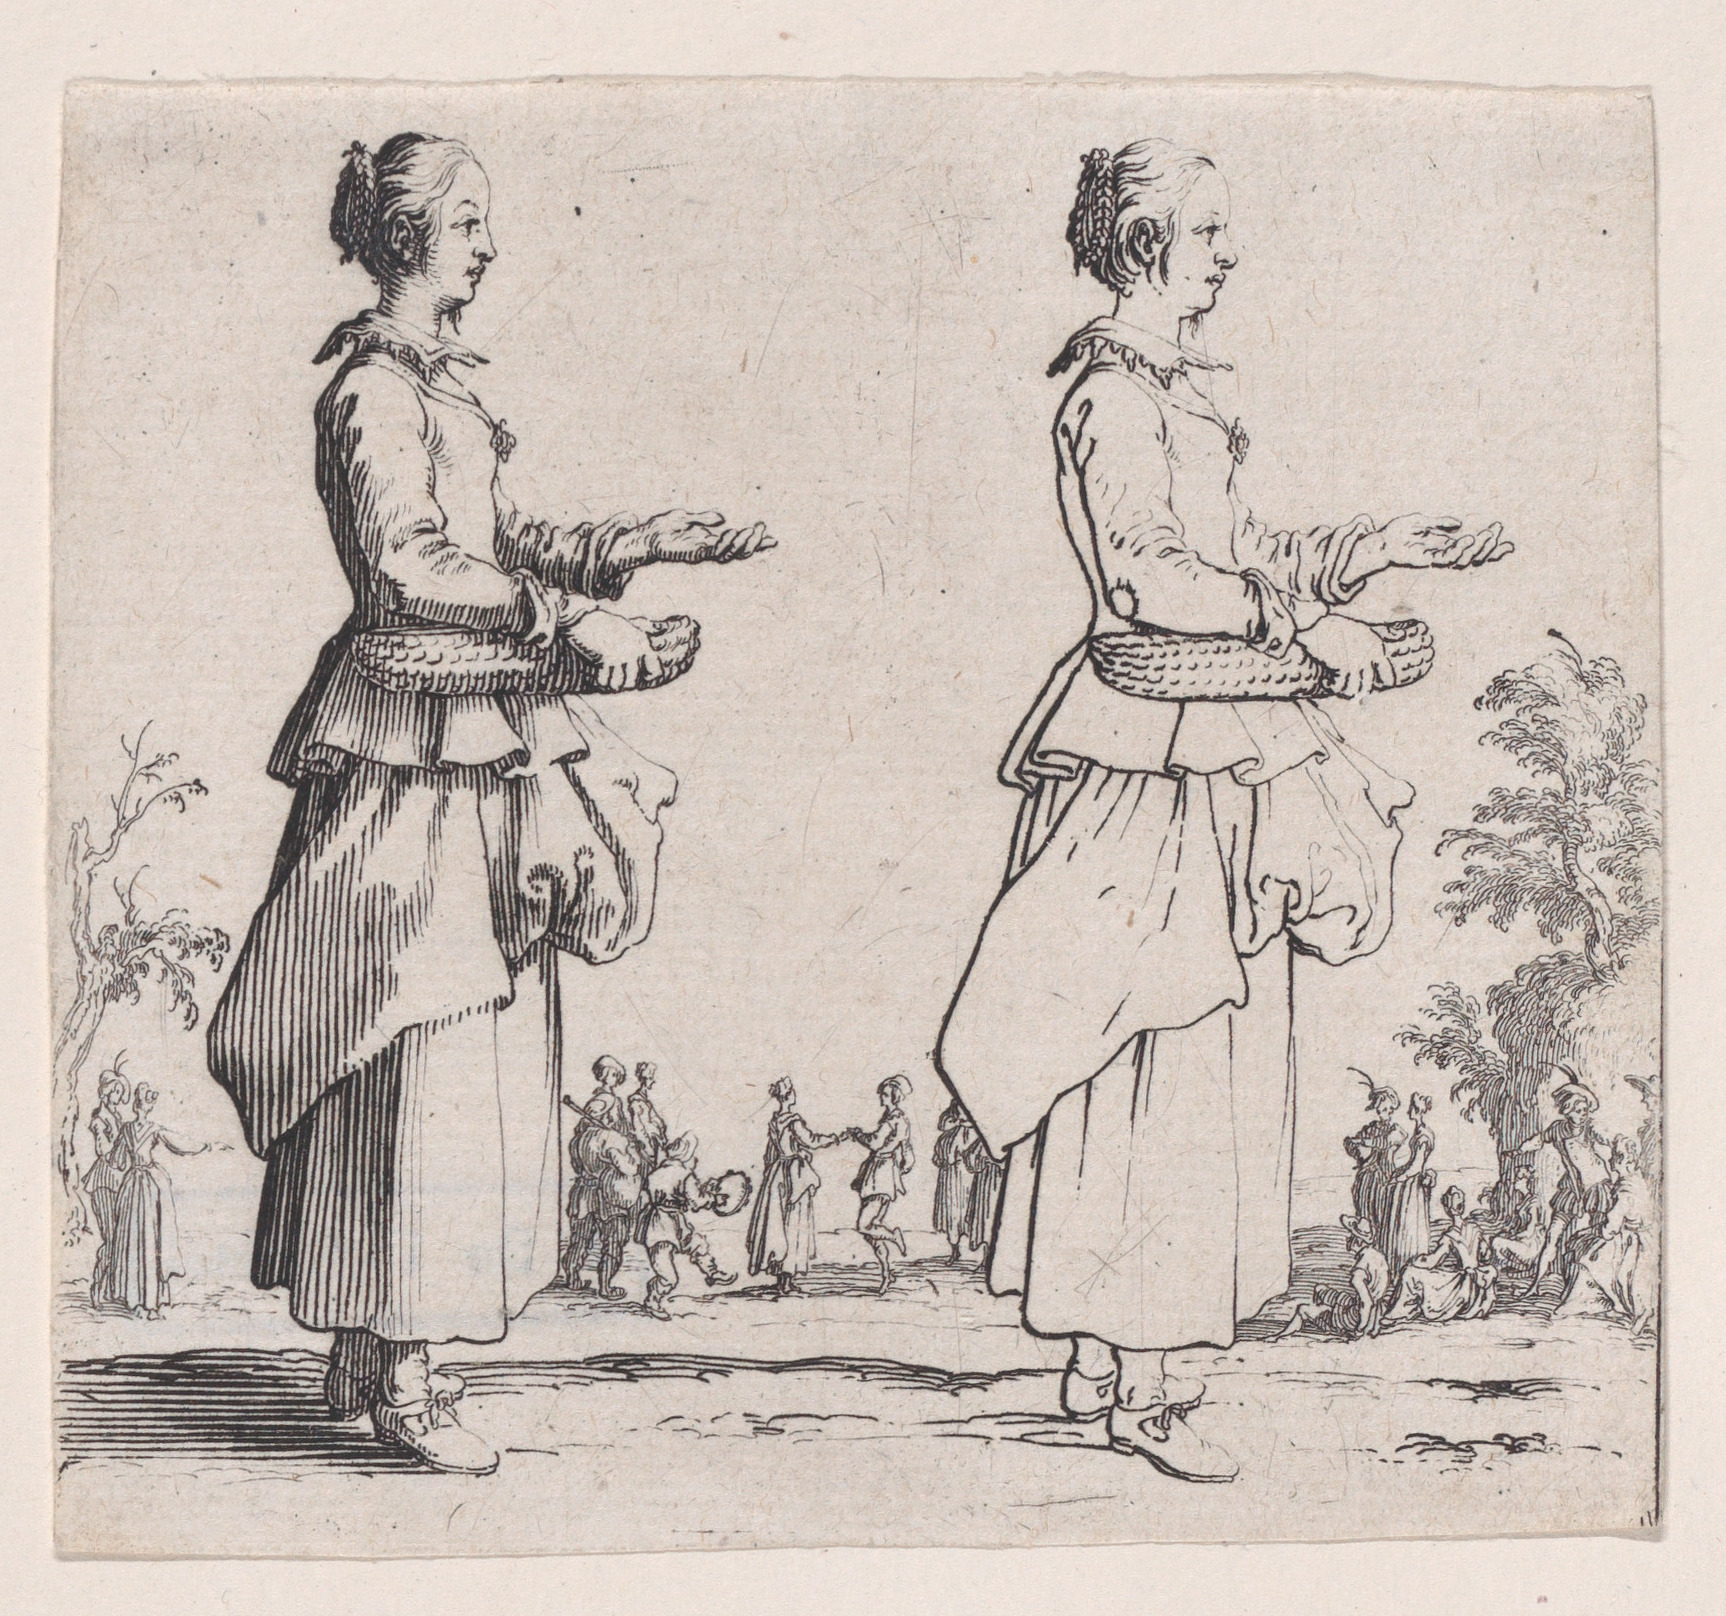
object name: print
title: La Paysanne Tournée a Droite et Tenant un Panier (The Peasant Woman Turned to the Right and Holding a Basket), from "Varie Figure" (Various Figures)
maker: jacques callot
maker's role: artist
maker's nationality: french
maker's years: 1592-1635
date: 1620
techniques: etching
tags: women,baskets